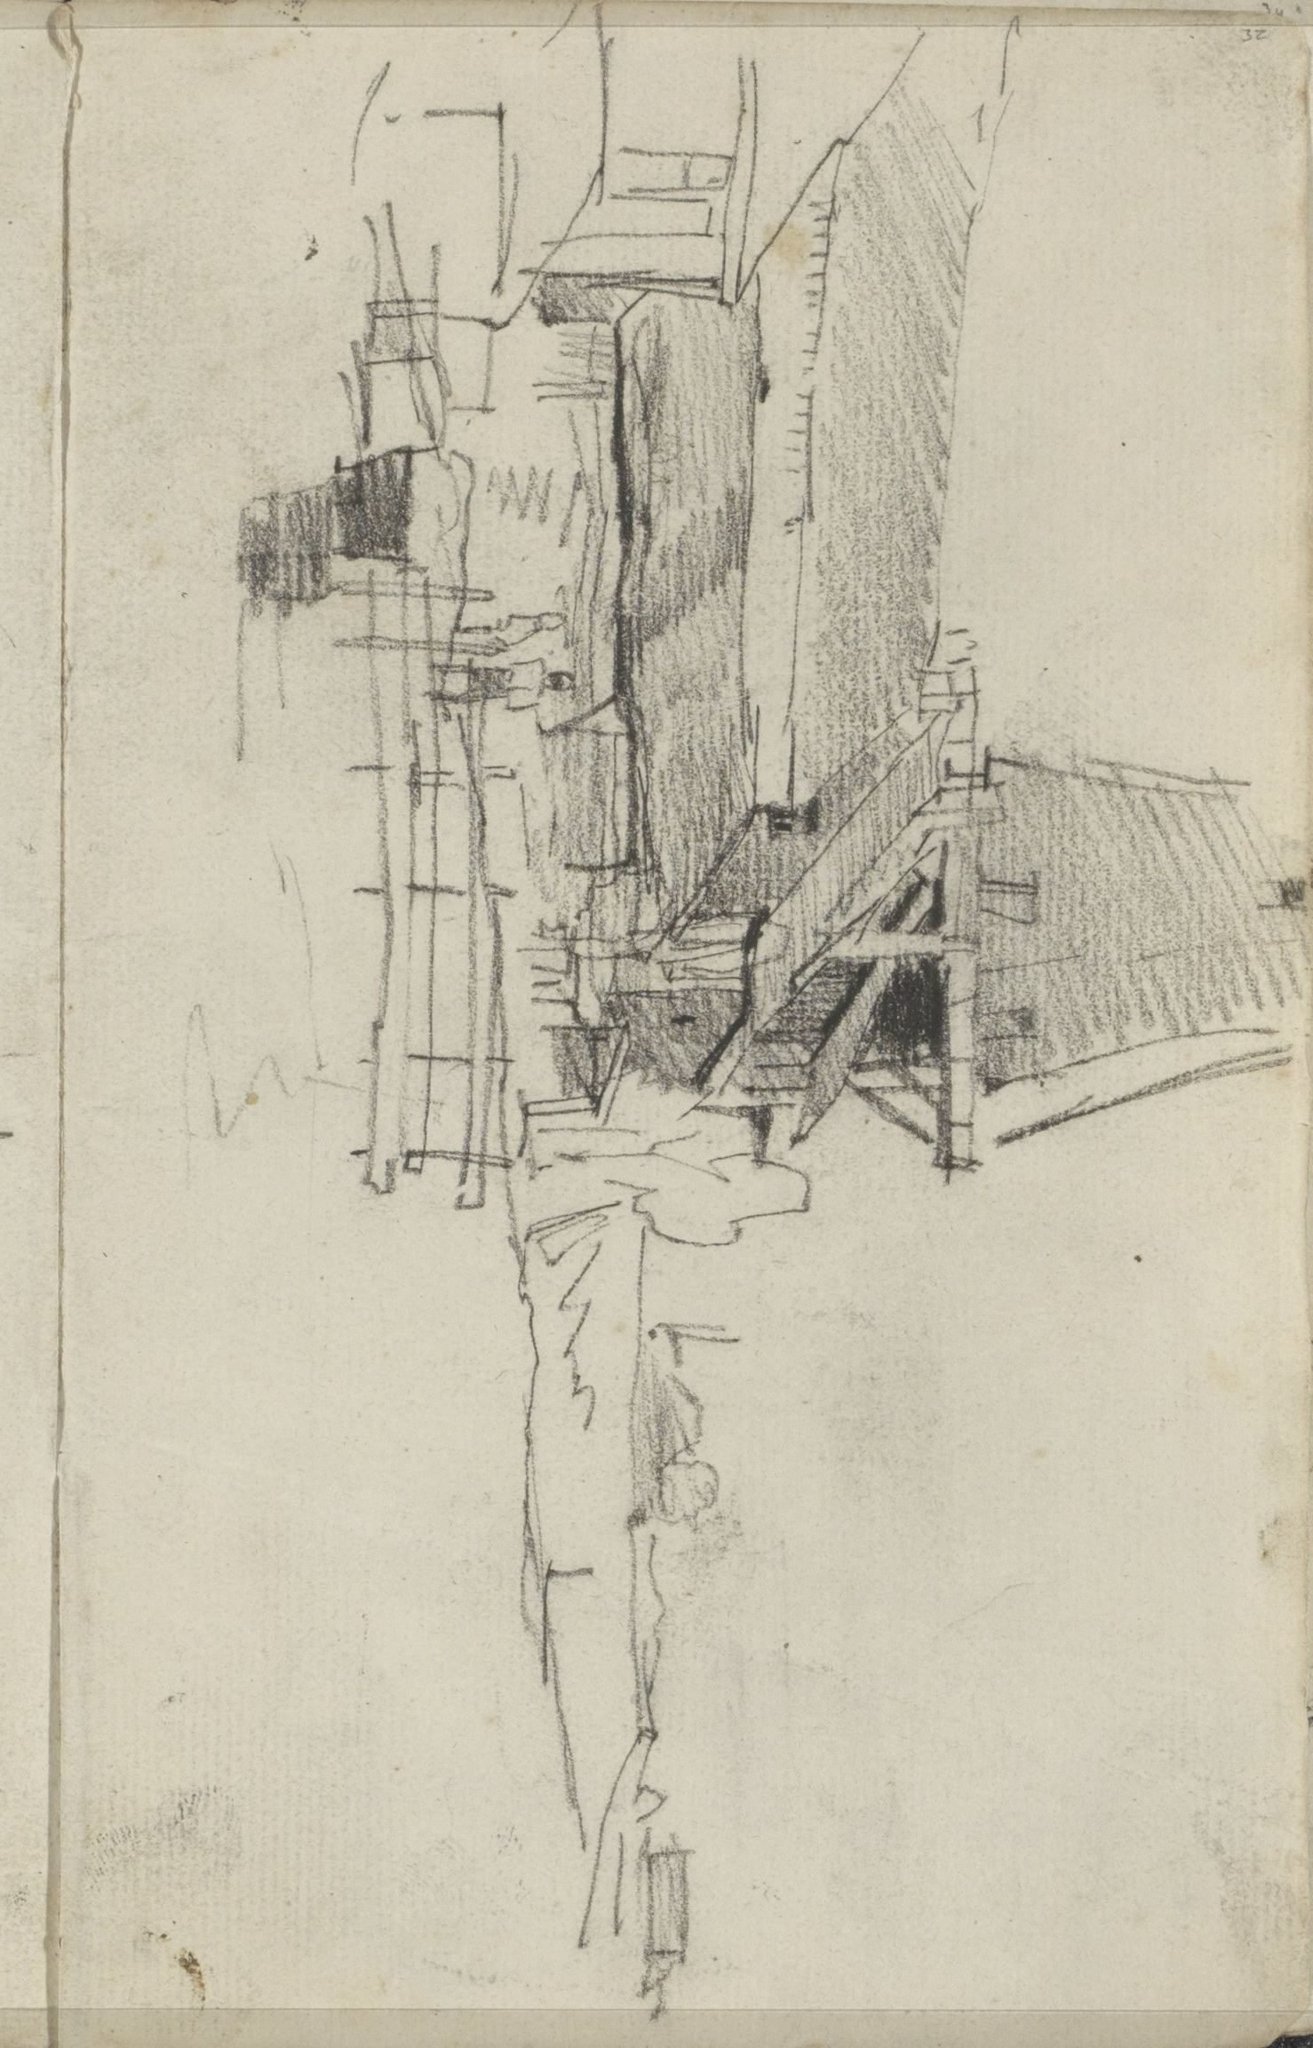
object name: sketchbook leaf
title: Molen aan het water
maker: george hendrik breitner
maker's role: draughtsman, painter, print maker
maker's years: 1857-1923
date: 1880-1882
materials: chalk, paper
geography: the hague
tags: landscapes with waters, waterscapes, seascapes (in the temperate zone), windmill in landscape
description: Pagina 32 uit een schetsboek met 23 bladen.